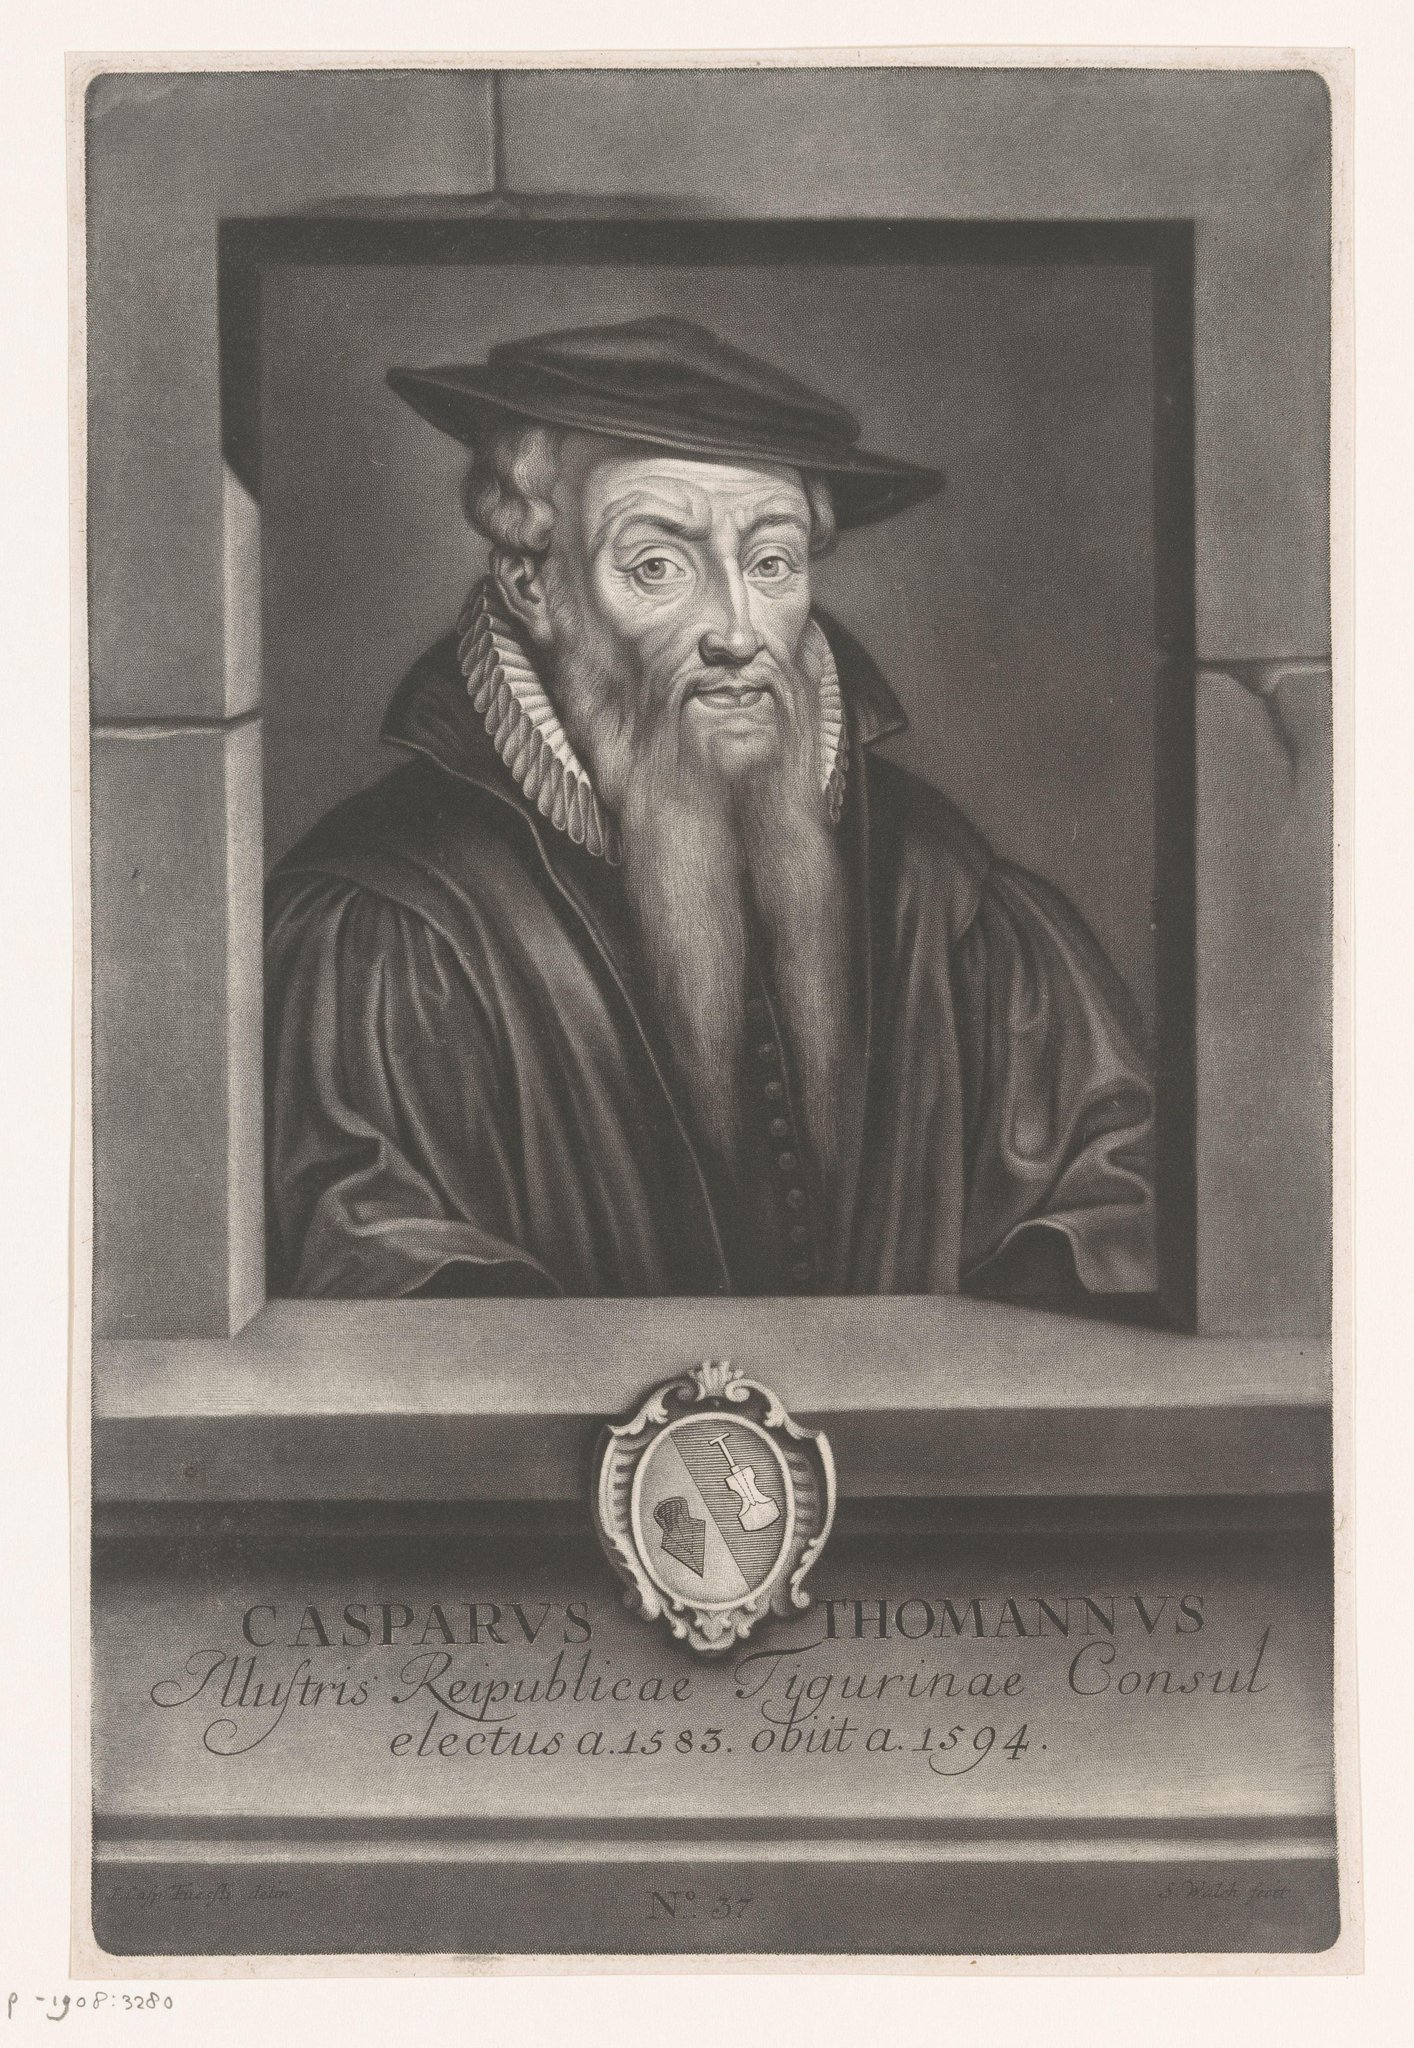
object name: print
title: Portret van Caspar Thomann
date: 1731-1788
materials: paper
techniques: mezzotint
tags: mayor, historical persons, armorial bearing, heraldry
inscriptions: collector's mark: Lugt 2228